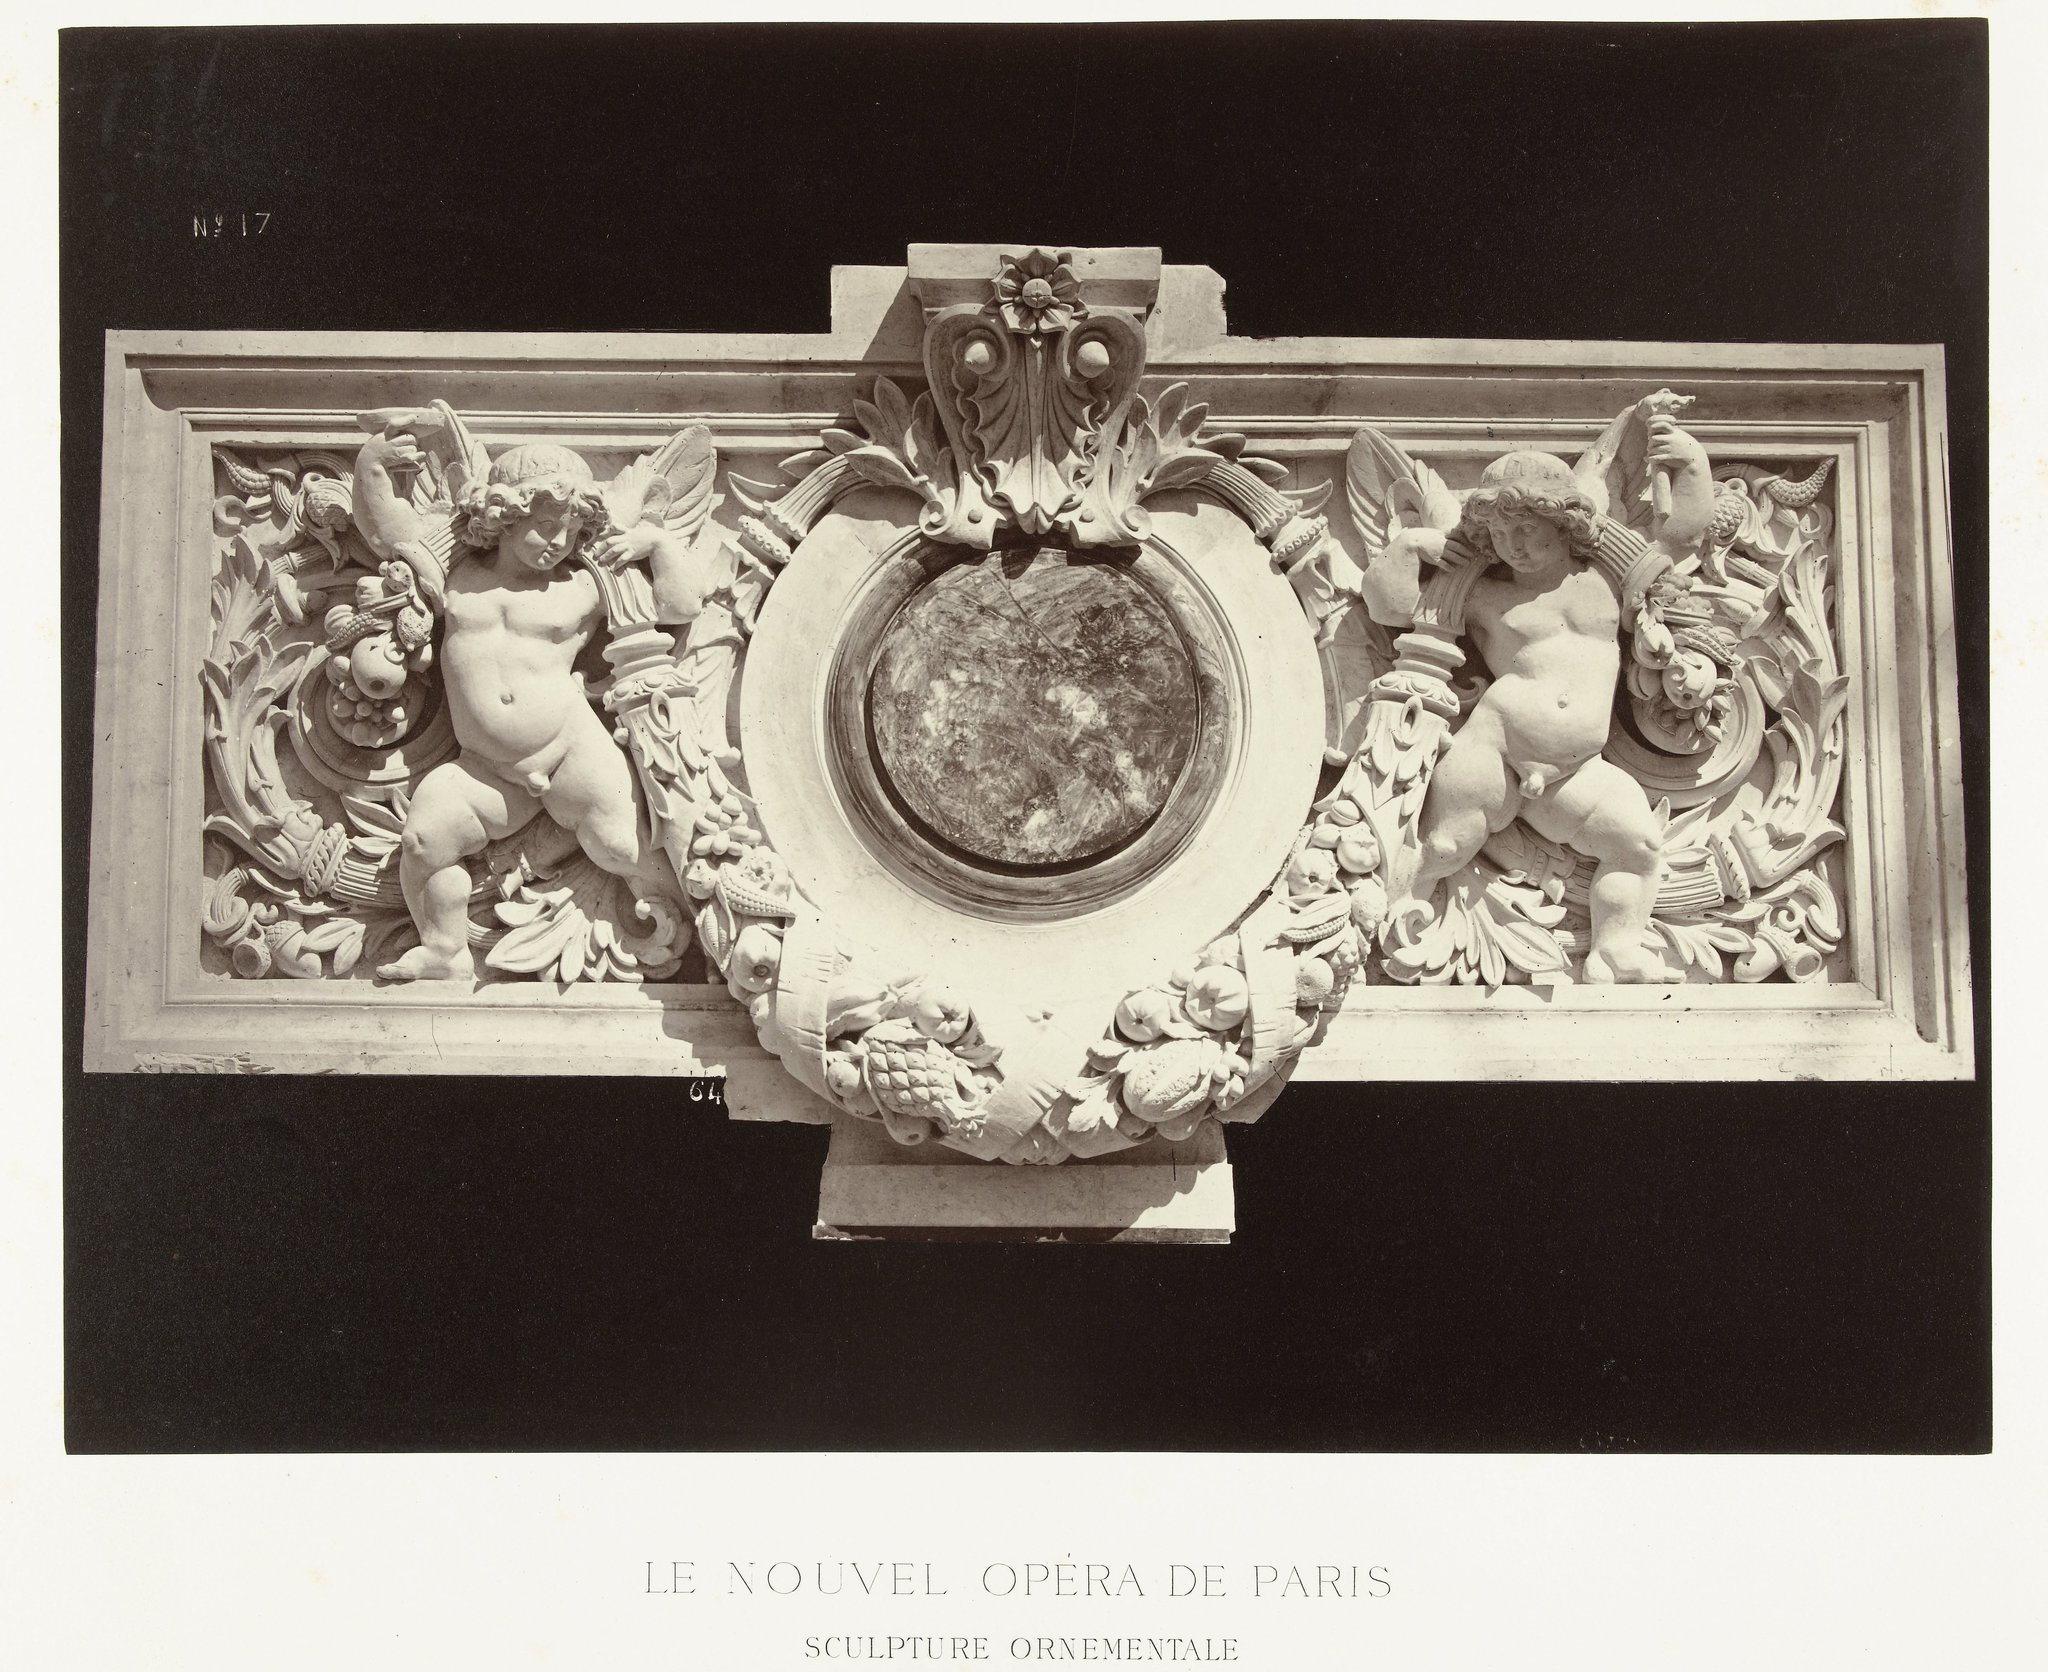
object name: photograph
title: Reliëf met engeltjes naast een medaillon, samen houden zij een fruitslinger vast.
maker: louis-emile durandelle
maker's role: fotograaf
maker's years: 1839-1917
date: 1878-1881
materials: photographic support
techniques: albumen print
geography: paris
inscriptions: number: ‘9’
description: bij boek in Bibliotheek RMA, Zie Frizot, pp. 217-223, vgl G. Vicaire, Manuel de l'amateur de livres du XIXe siècle, vol. 3, column 870.